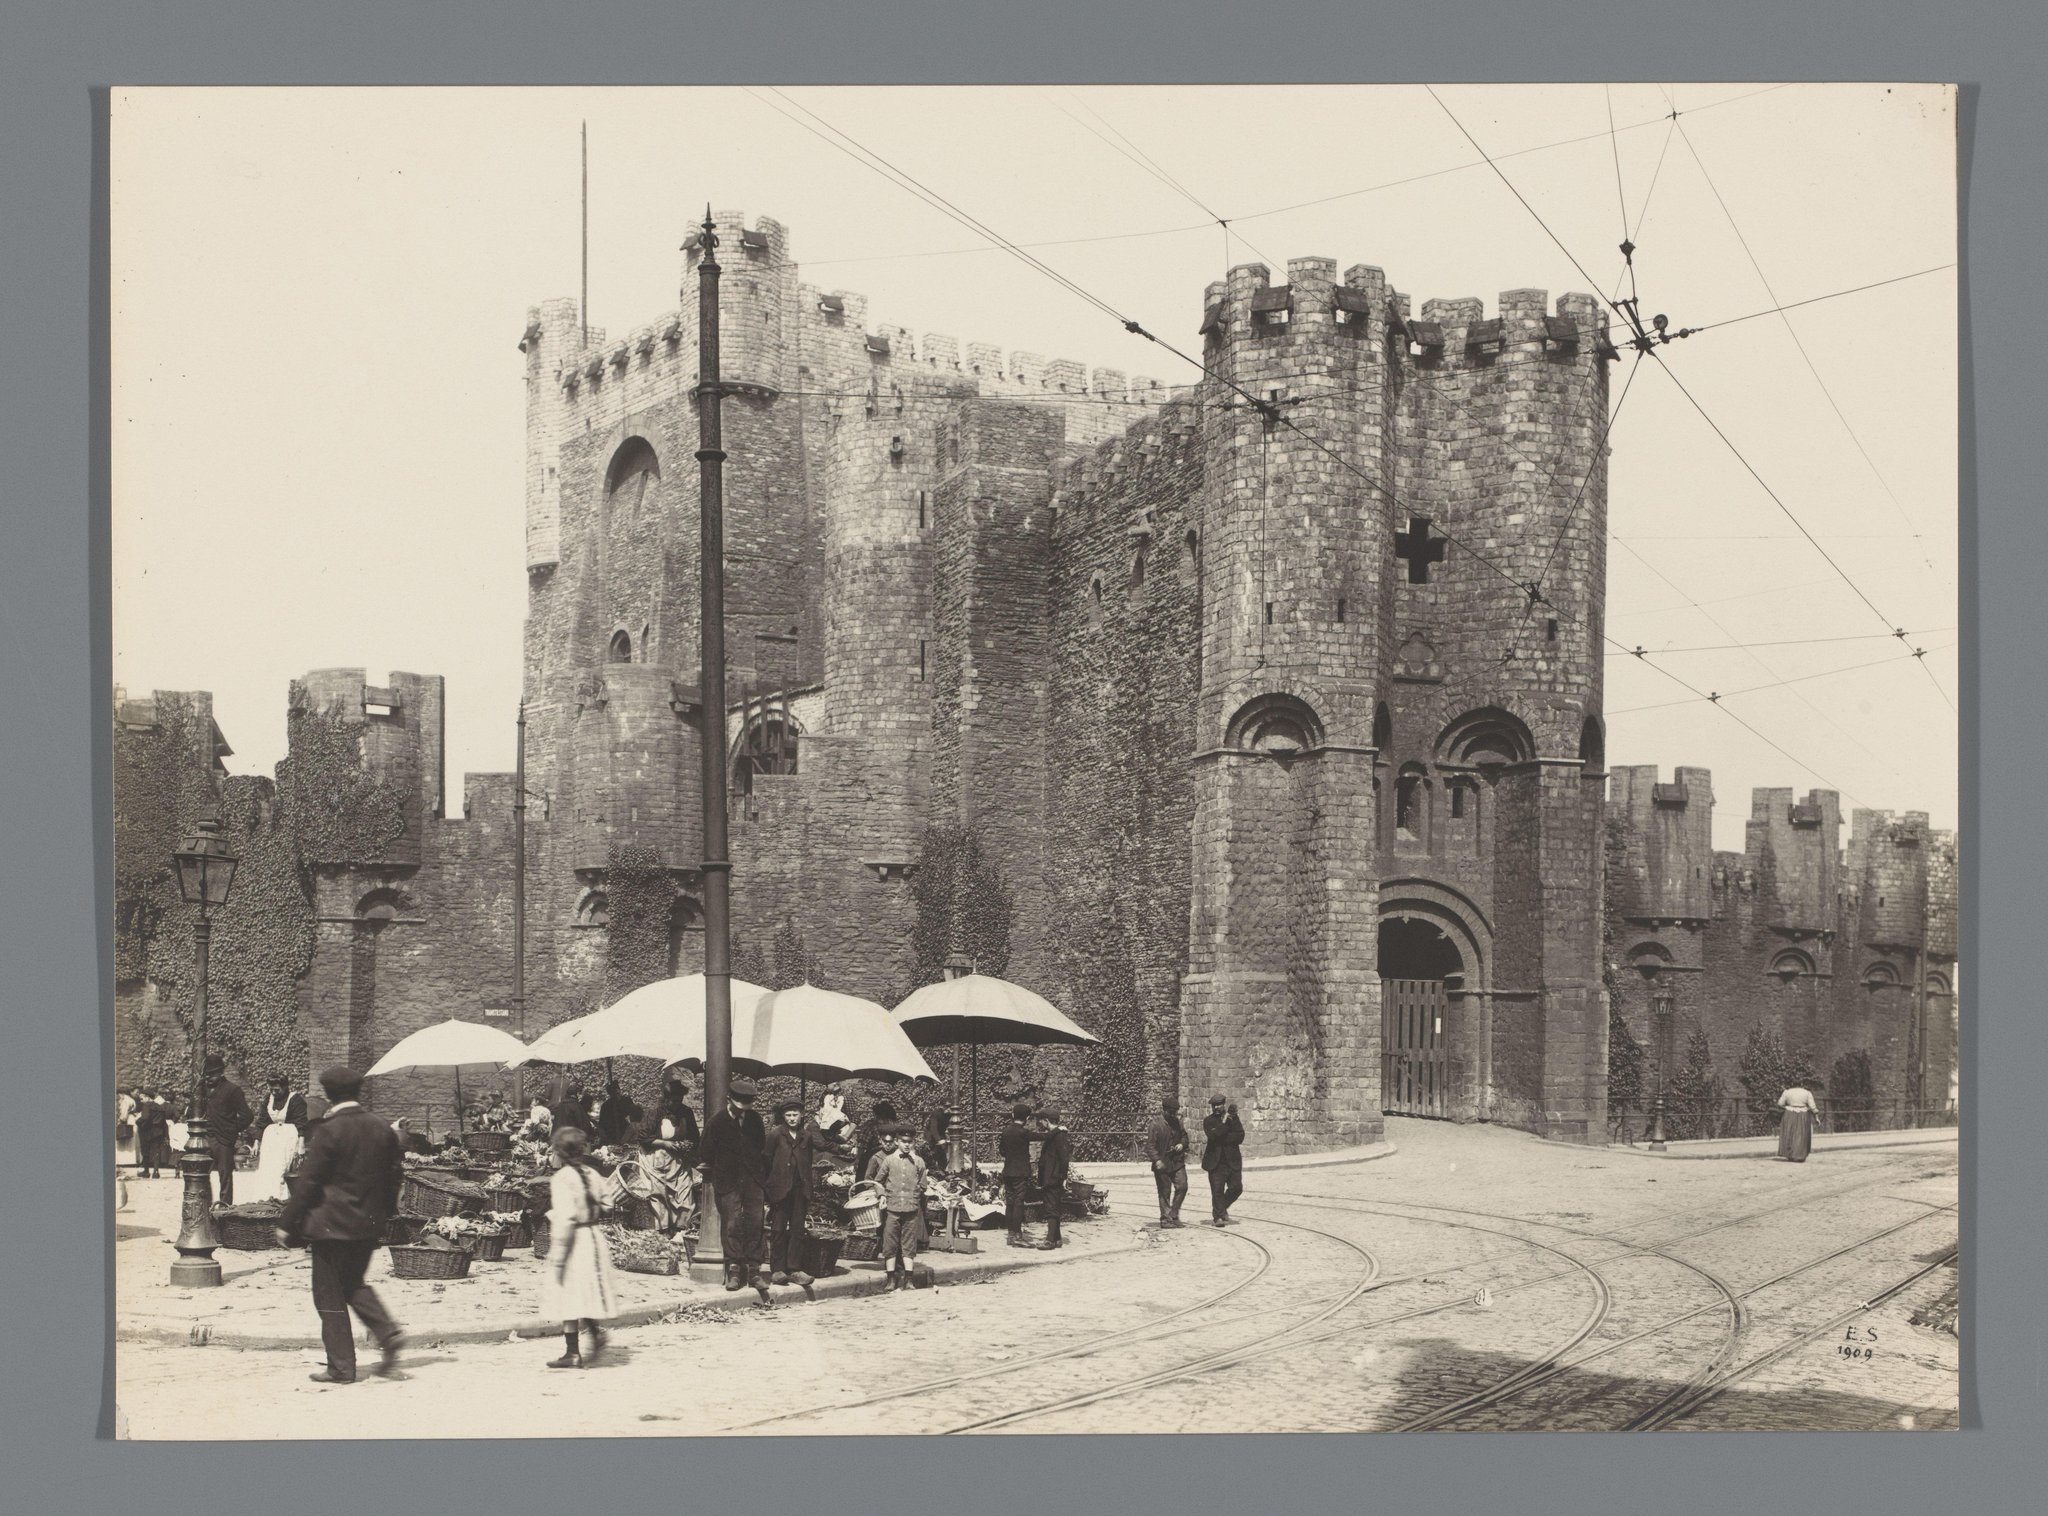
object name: photograph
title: Gent. Gravensteen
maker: Anonymous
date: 1909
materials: photographic support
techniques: gelatin silver print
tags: gravensteen